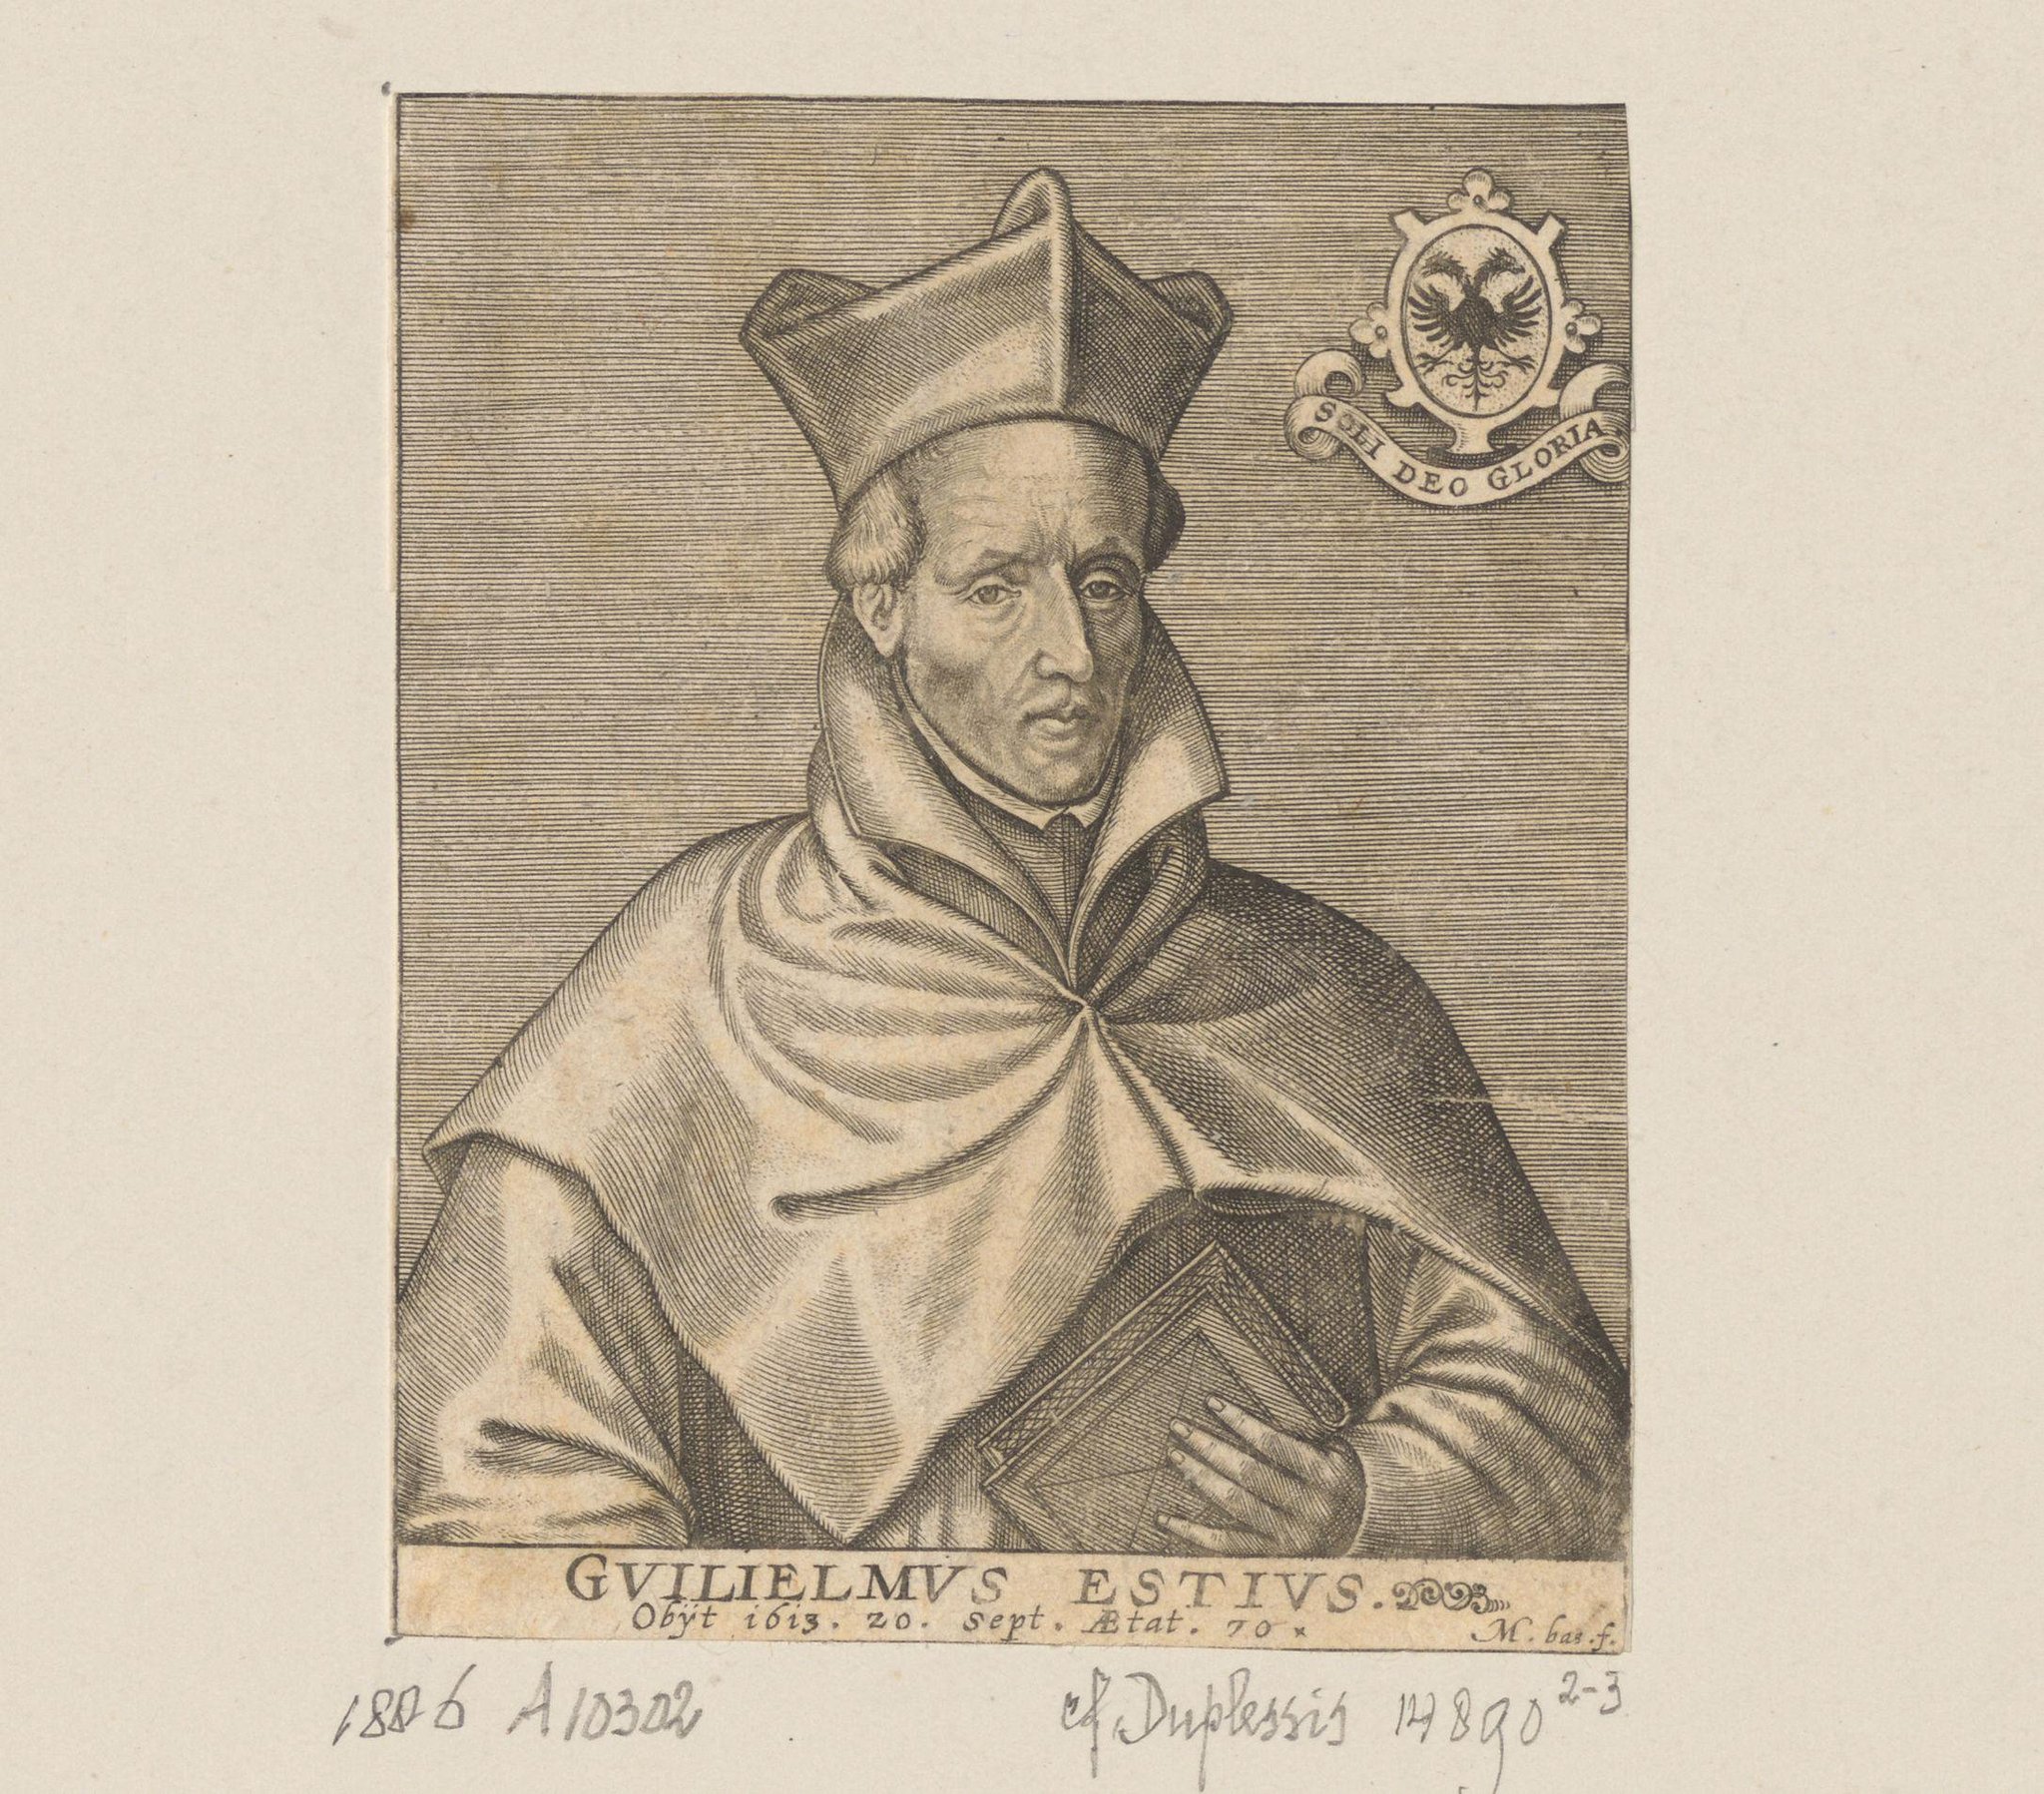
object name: print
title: Portret van Willem Hessels van Est op 70-jarige leeftijd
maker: martin baes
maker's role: print maker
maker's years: 1604-1637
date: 1613-1637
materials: paper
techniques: engraving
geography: douai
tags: theologian, historical persons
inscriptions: collector's mark: Lugt 2228